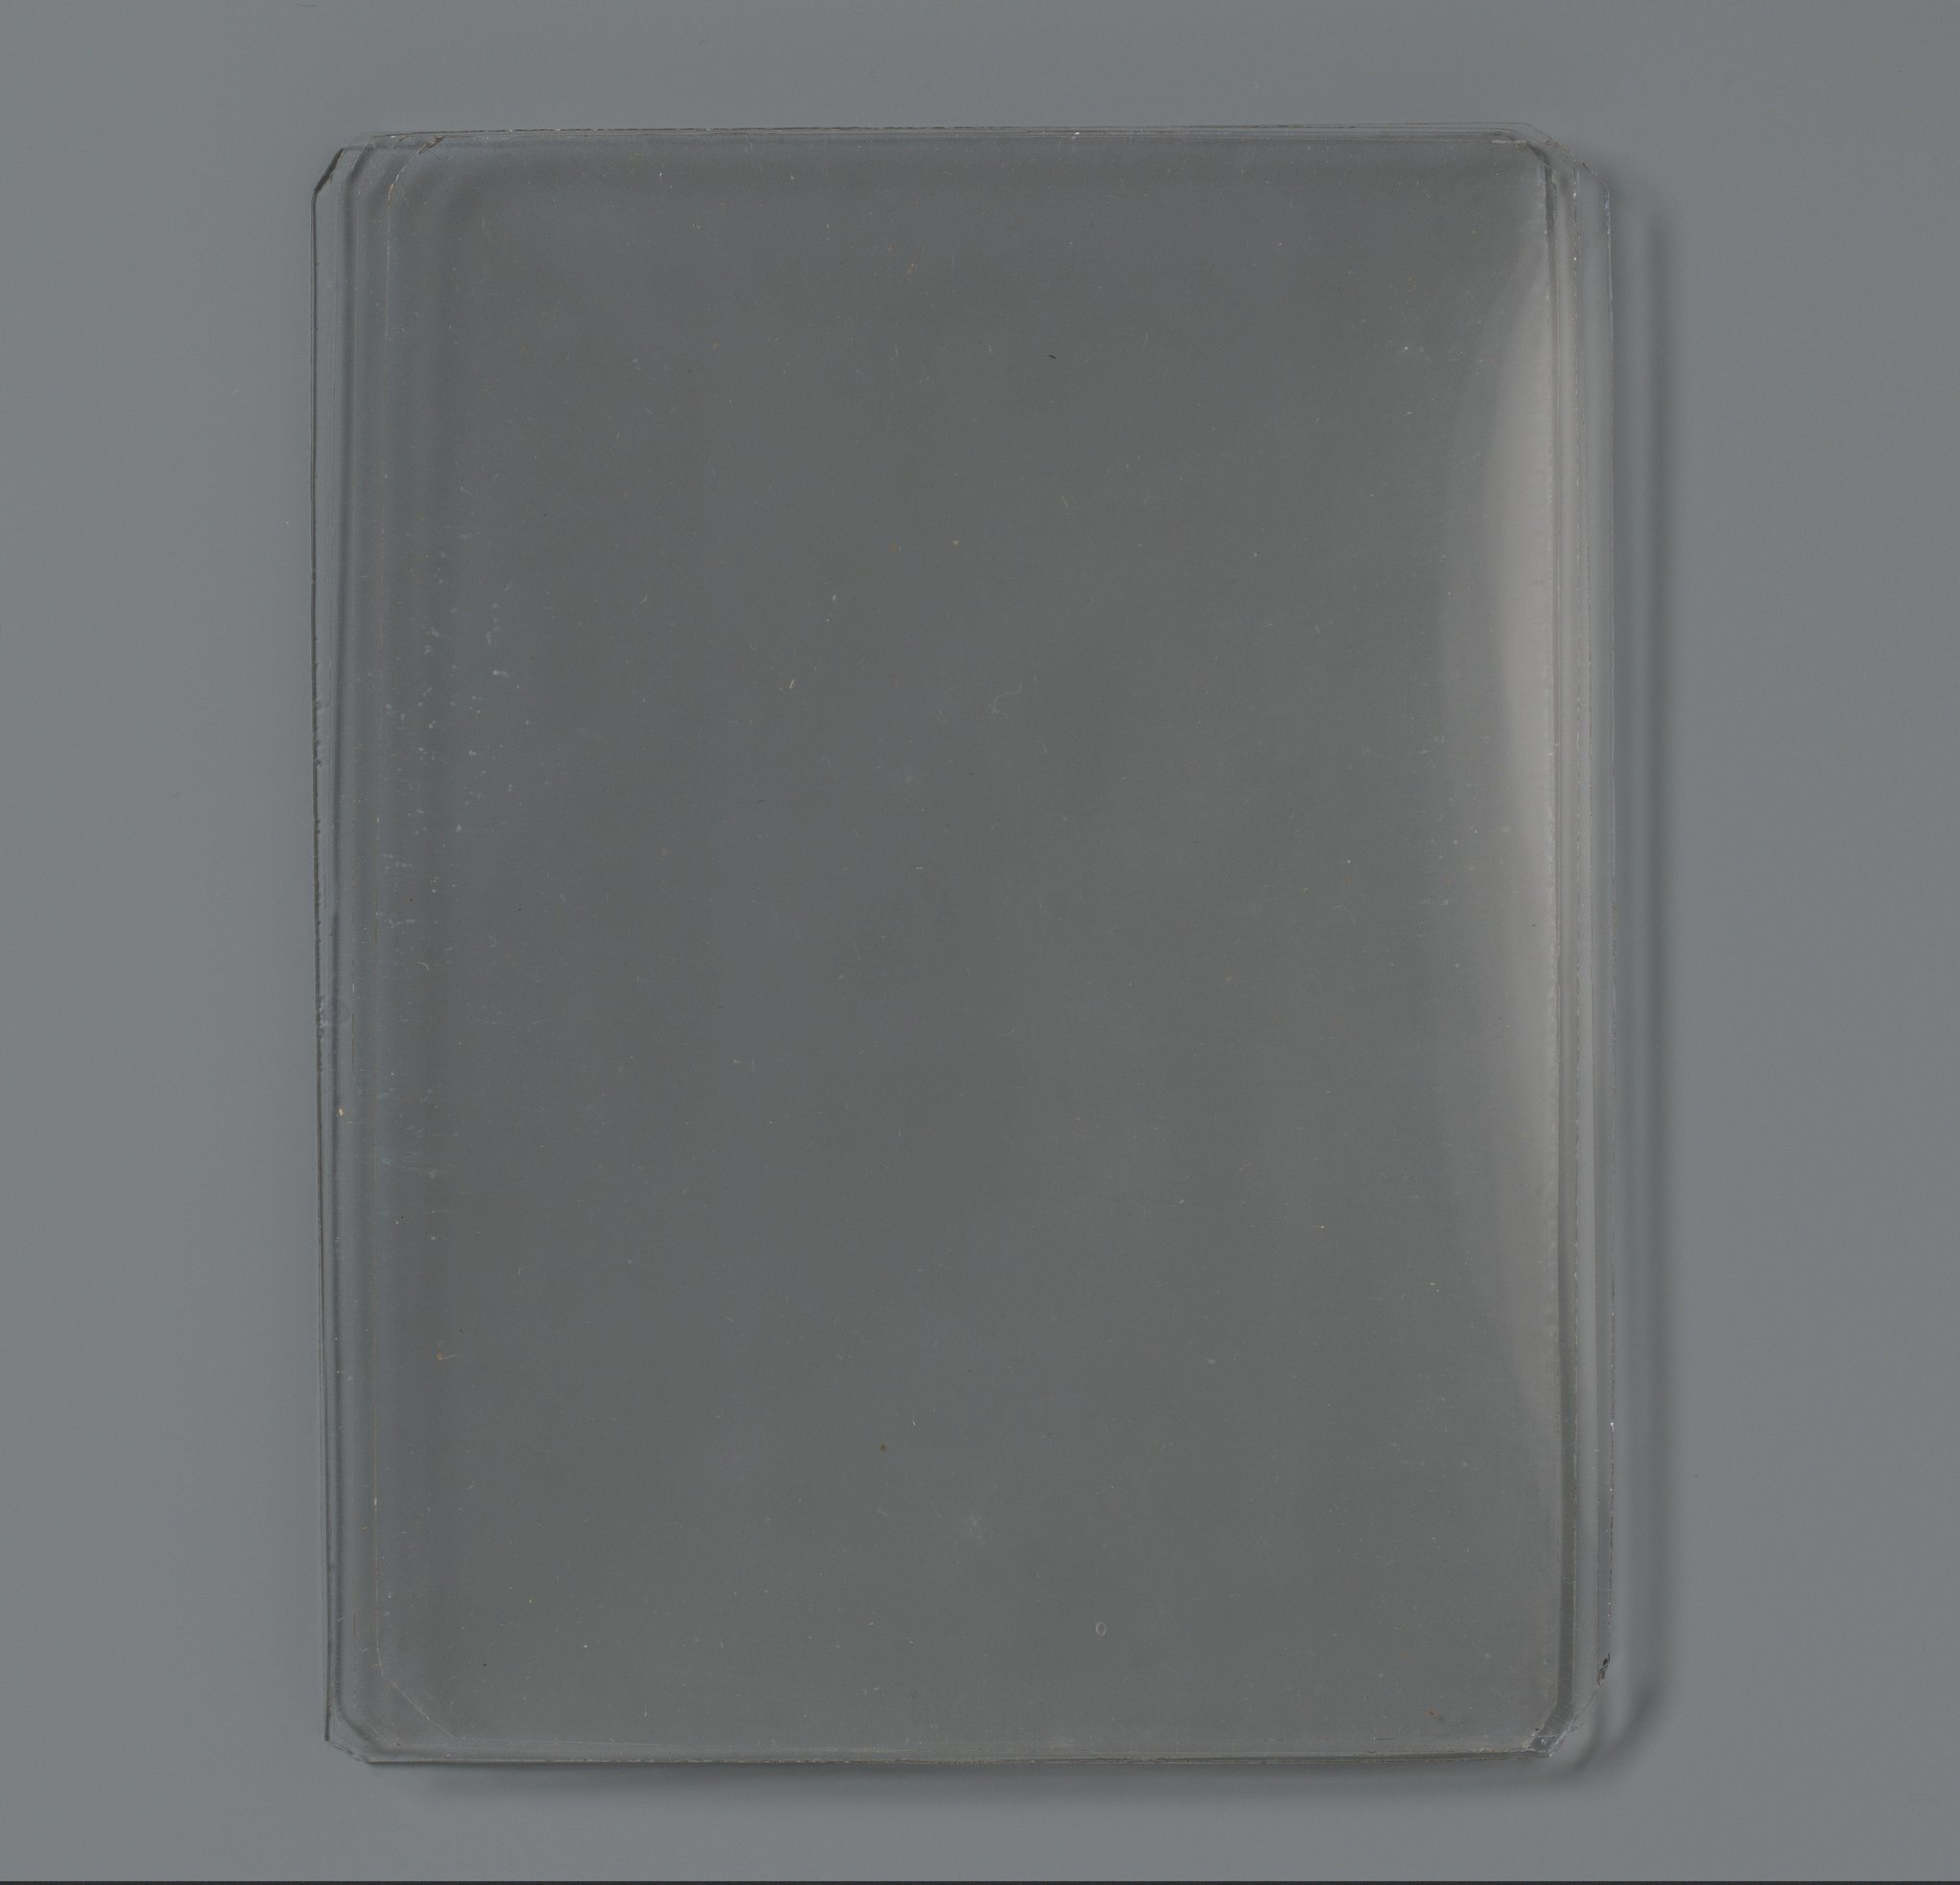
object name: crystoleum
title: Vijf bolle glazen platen voor crystolea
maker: Anonymous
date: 1880-1910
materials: glass